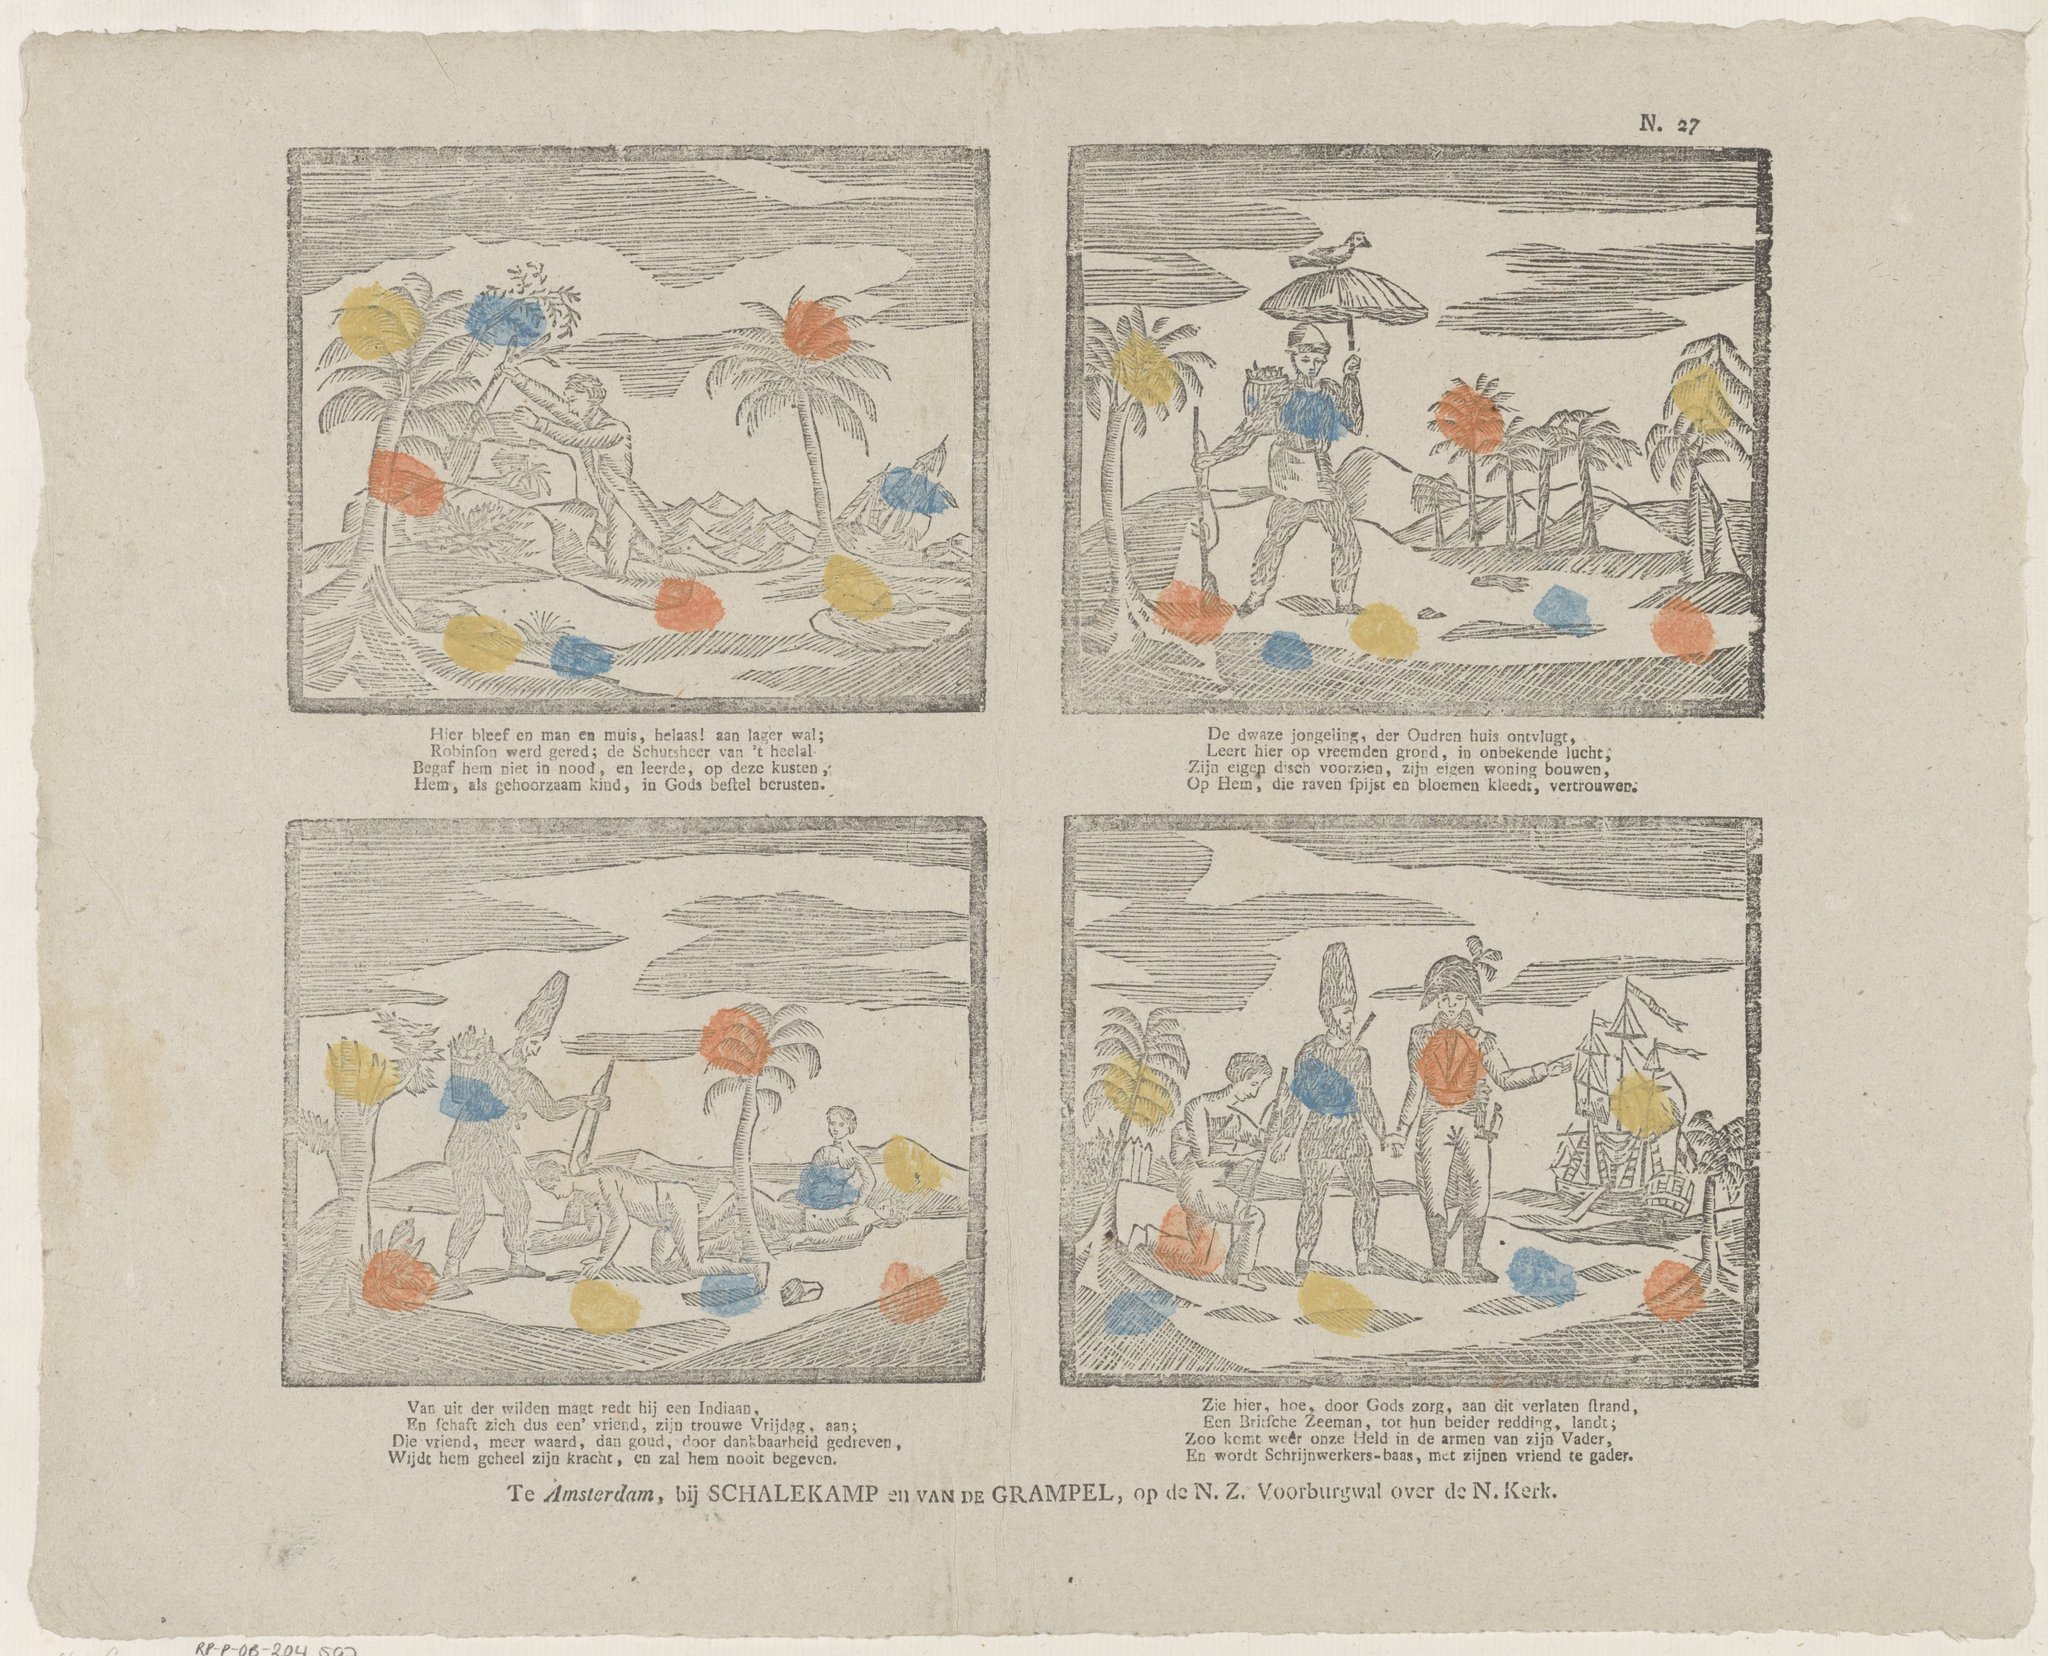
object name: popular print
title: Robinson Crusoe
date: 1822-1849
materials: paper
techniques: colour, letterpress printing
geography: deventer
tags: (scenes from) specific works of literature: defoe, robinson crusoe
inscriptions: collector's mark: Lugt 2760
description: Blad met 4 voorstellingen uit het verhaal van Robinson Crusoe die strandt op een eiland. Onder elke afbeelding een vierregelig vers. Genummerd rechtsboven: N. 27.